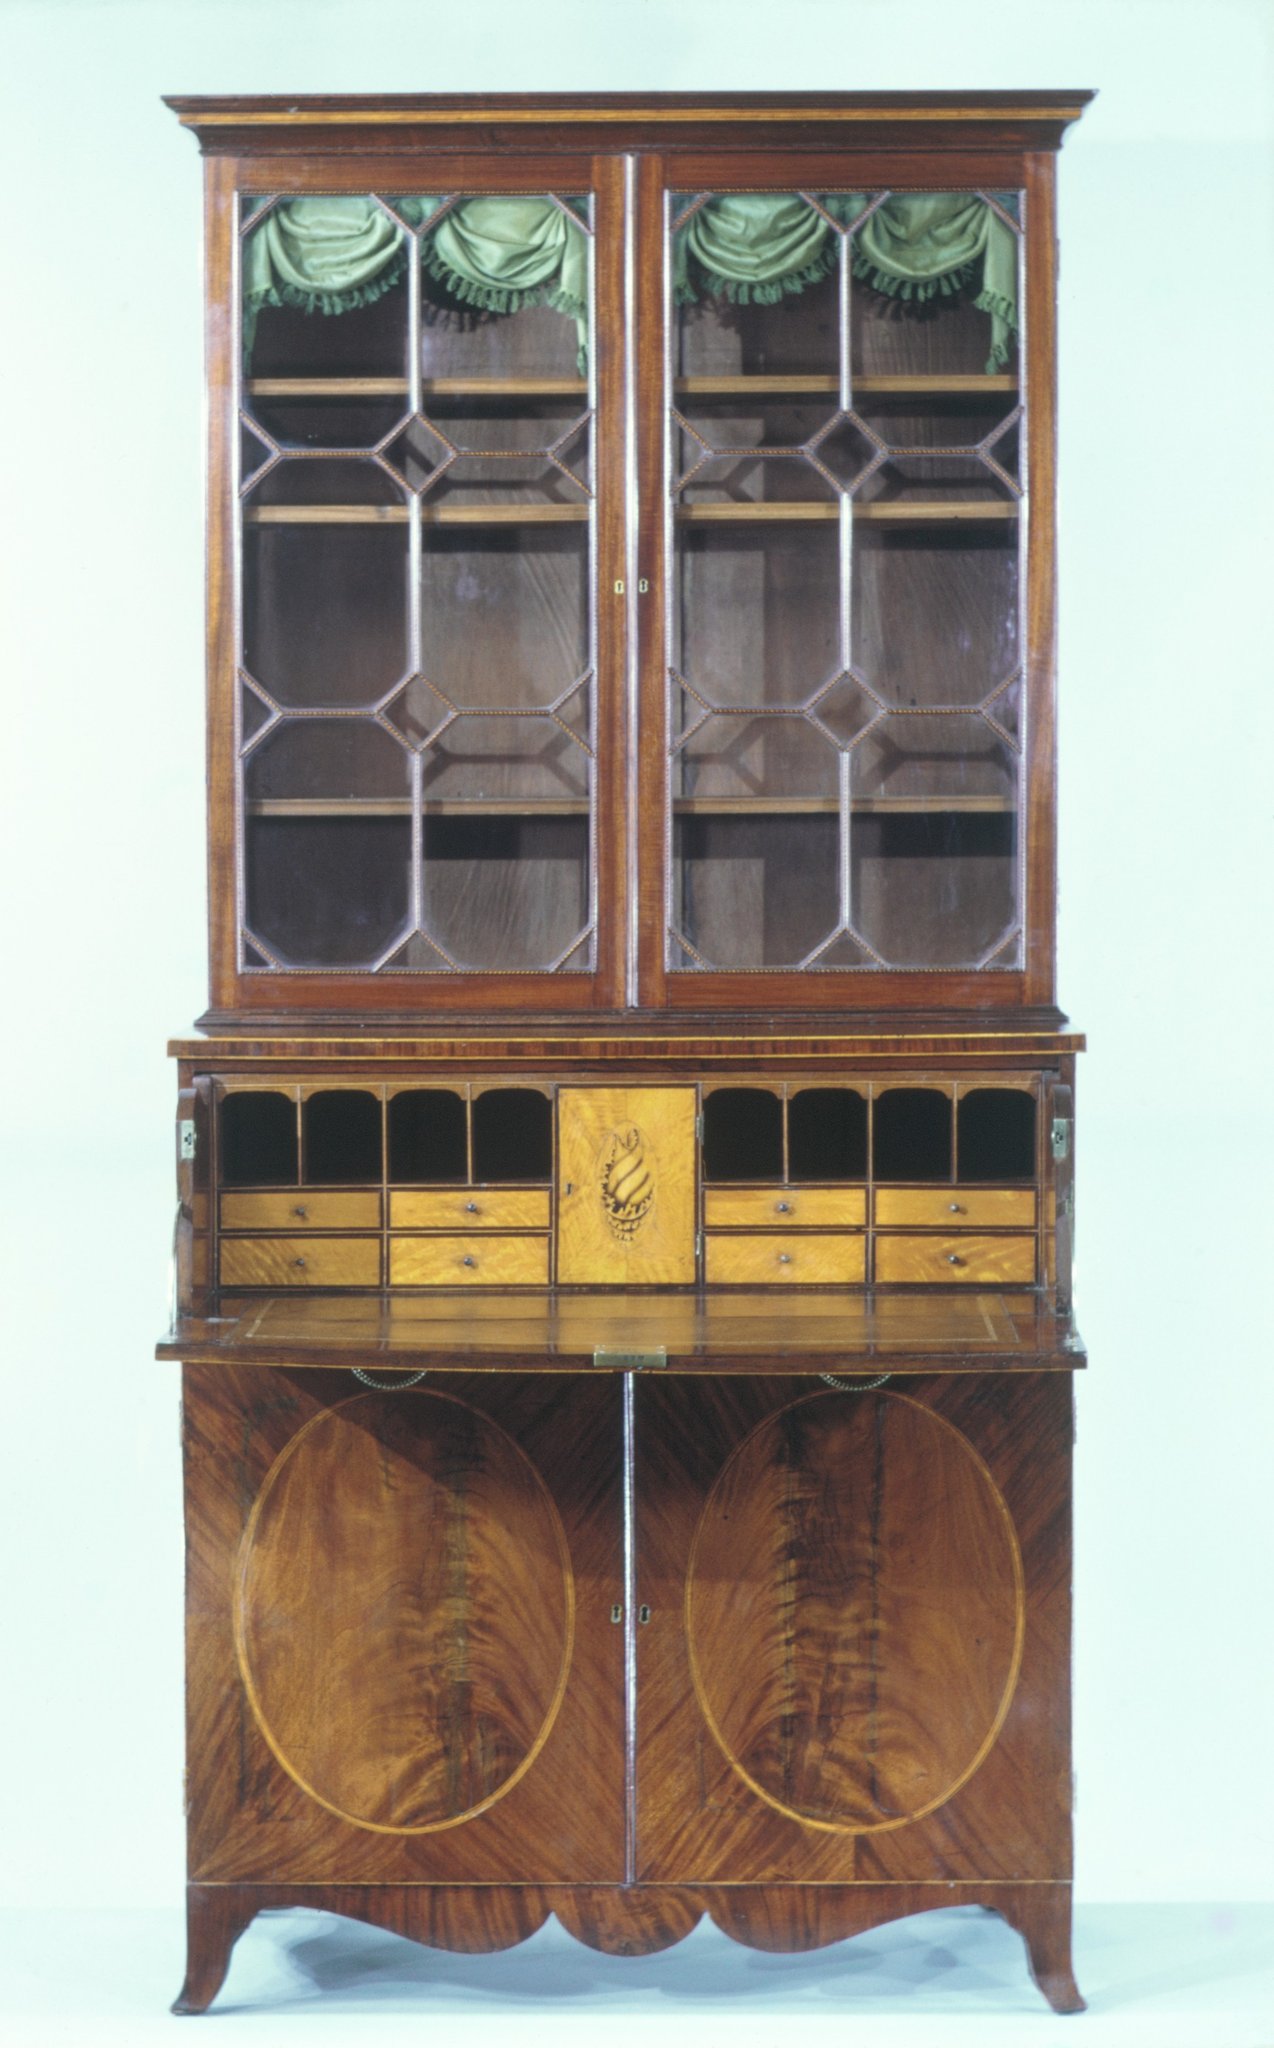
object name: secretary and bookcase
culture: american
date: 1795-1810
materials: wood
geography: united states